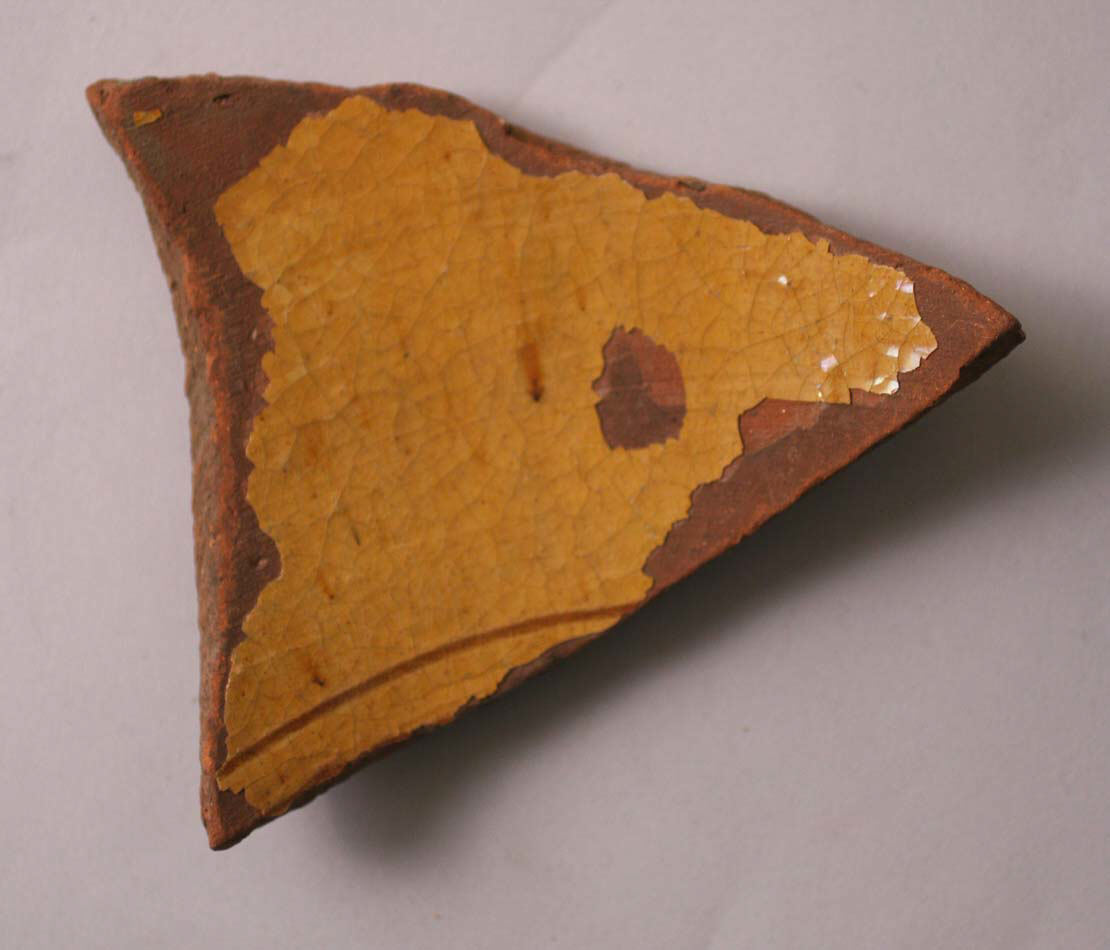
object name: ceramic fragment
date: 1301-1500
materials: earthenware, glaze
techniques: coloring, incising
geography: egypt